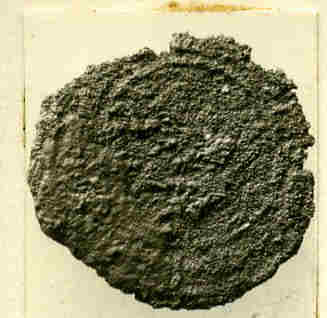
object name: coin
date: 701-900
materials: copper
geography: iran